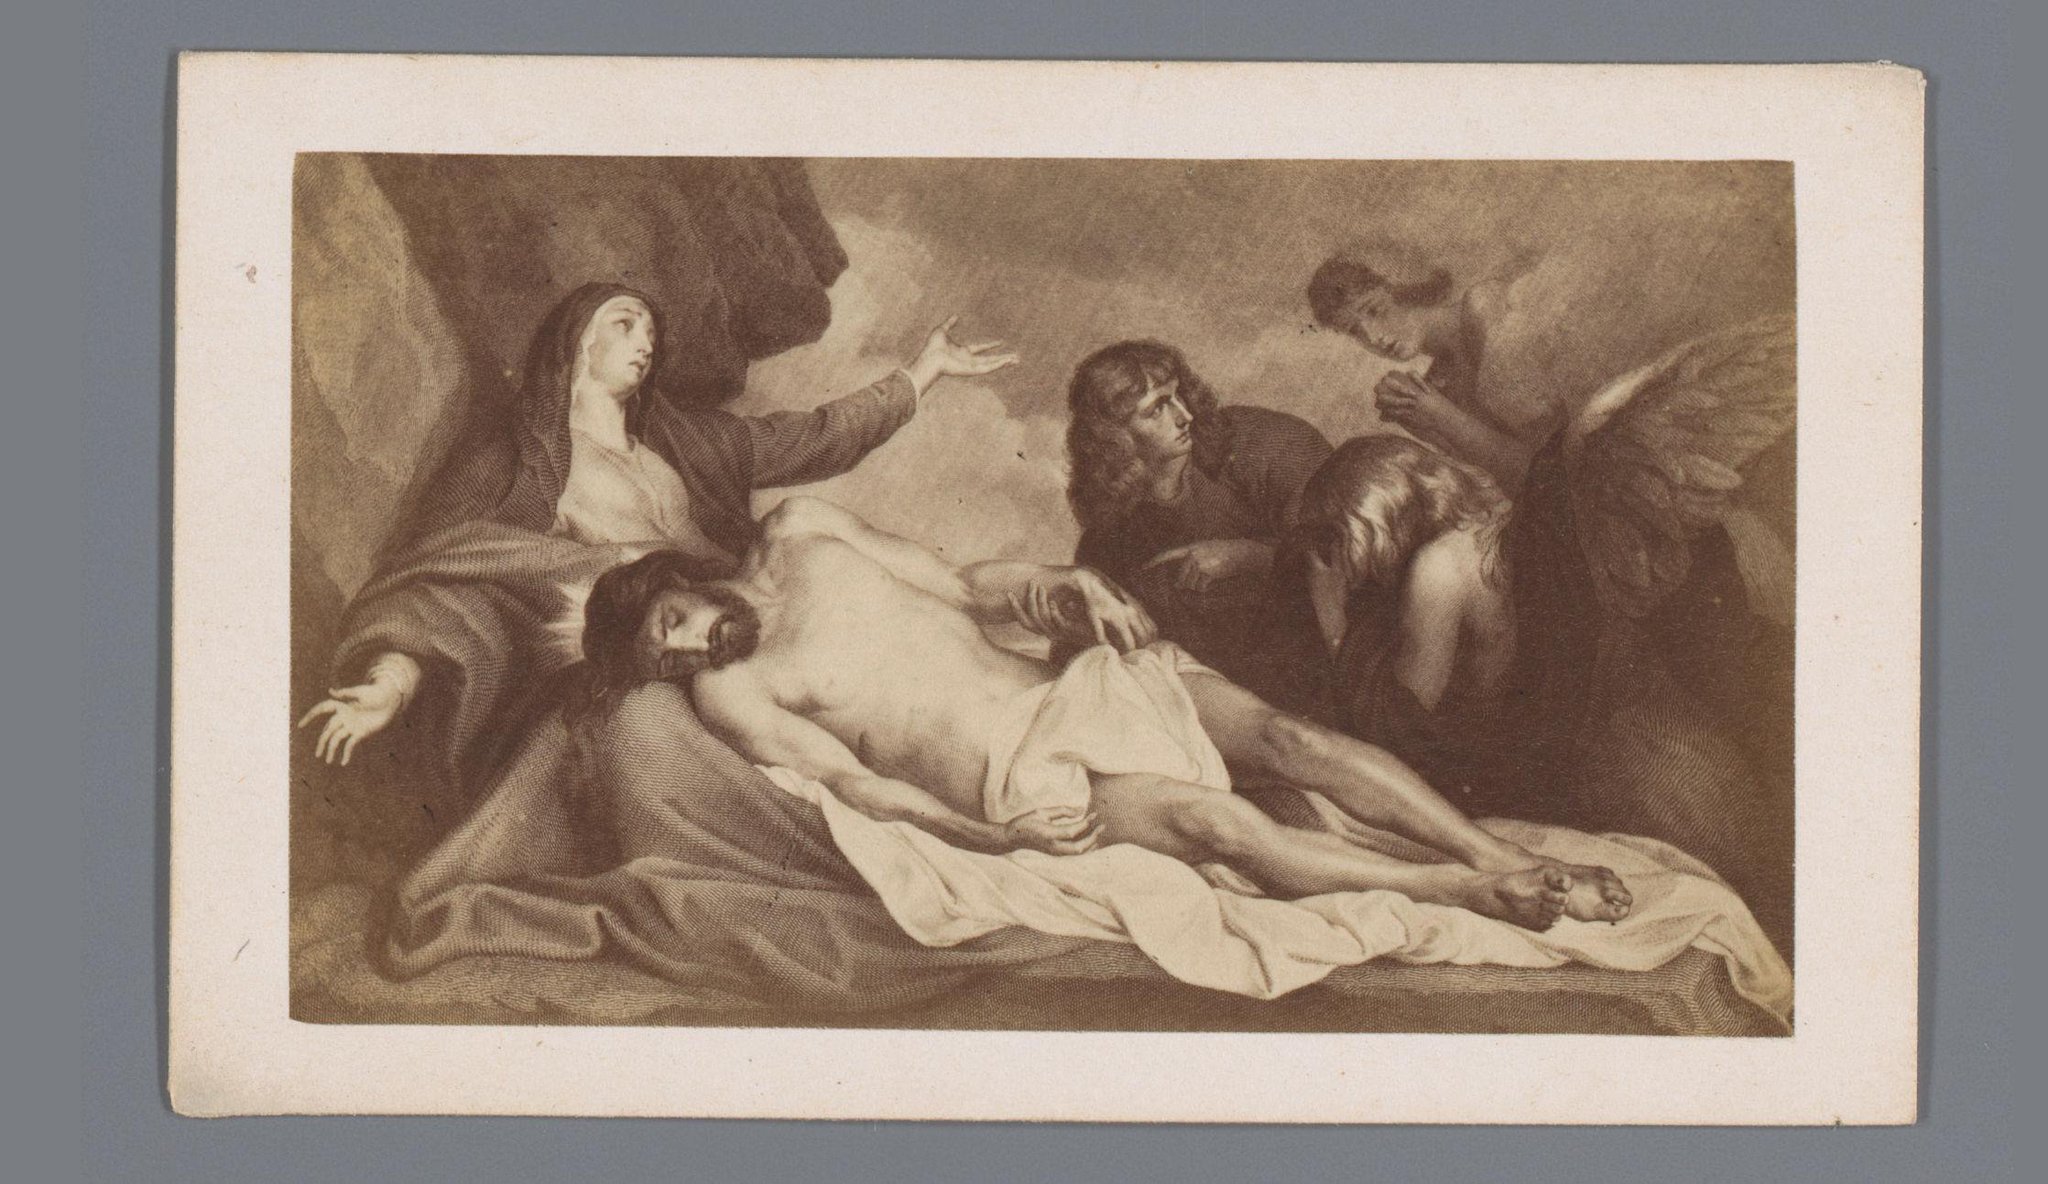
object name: reproduction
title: Van Dyck. Le Christ au tombeau. Musée d'Anvers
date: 1858-1866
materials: cardboard, paper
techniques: albumen print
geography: antwerp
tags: christ's body lying on the ground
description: Het oorspronkelijke schilderij hangt in het Museum voor Schone Kunsten te Antwerpen.